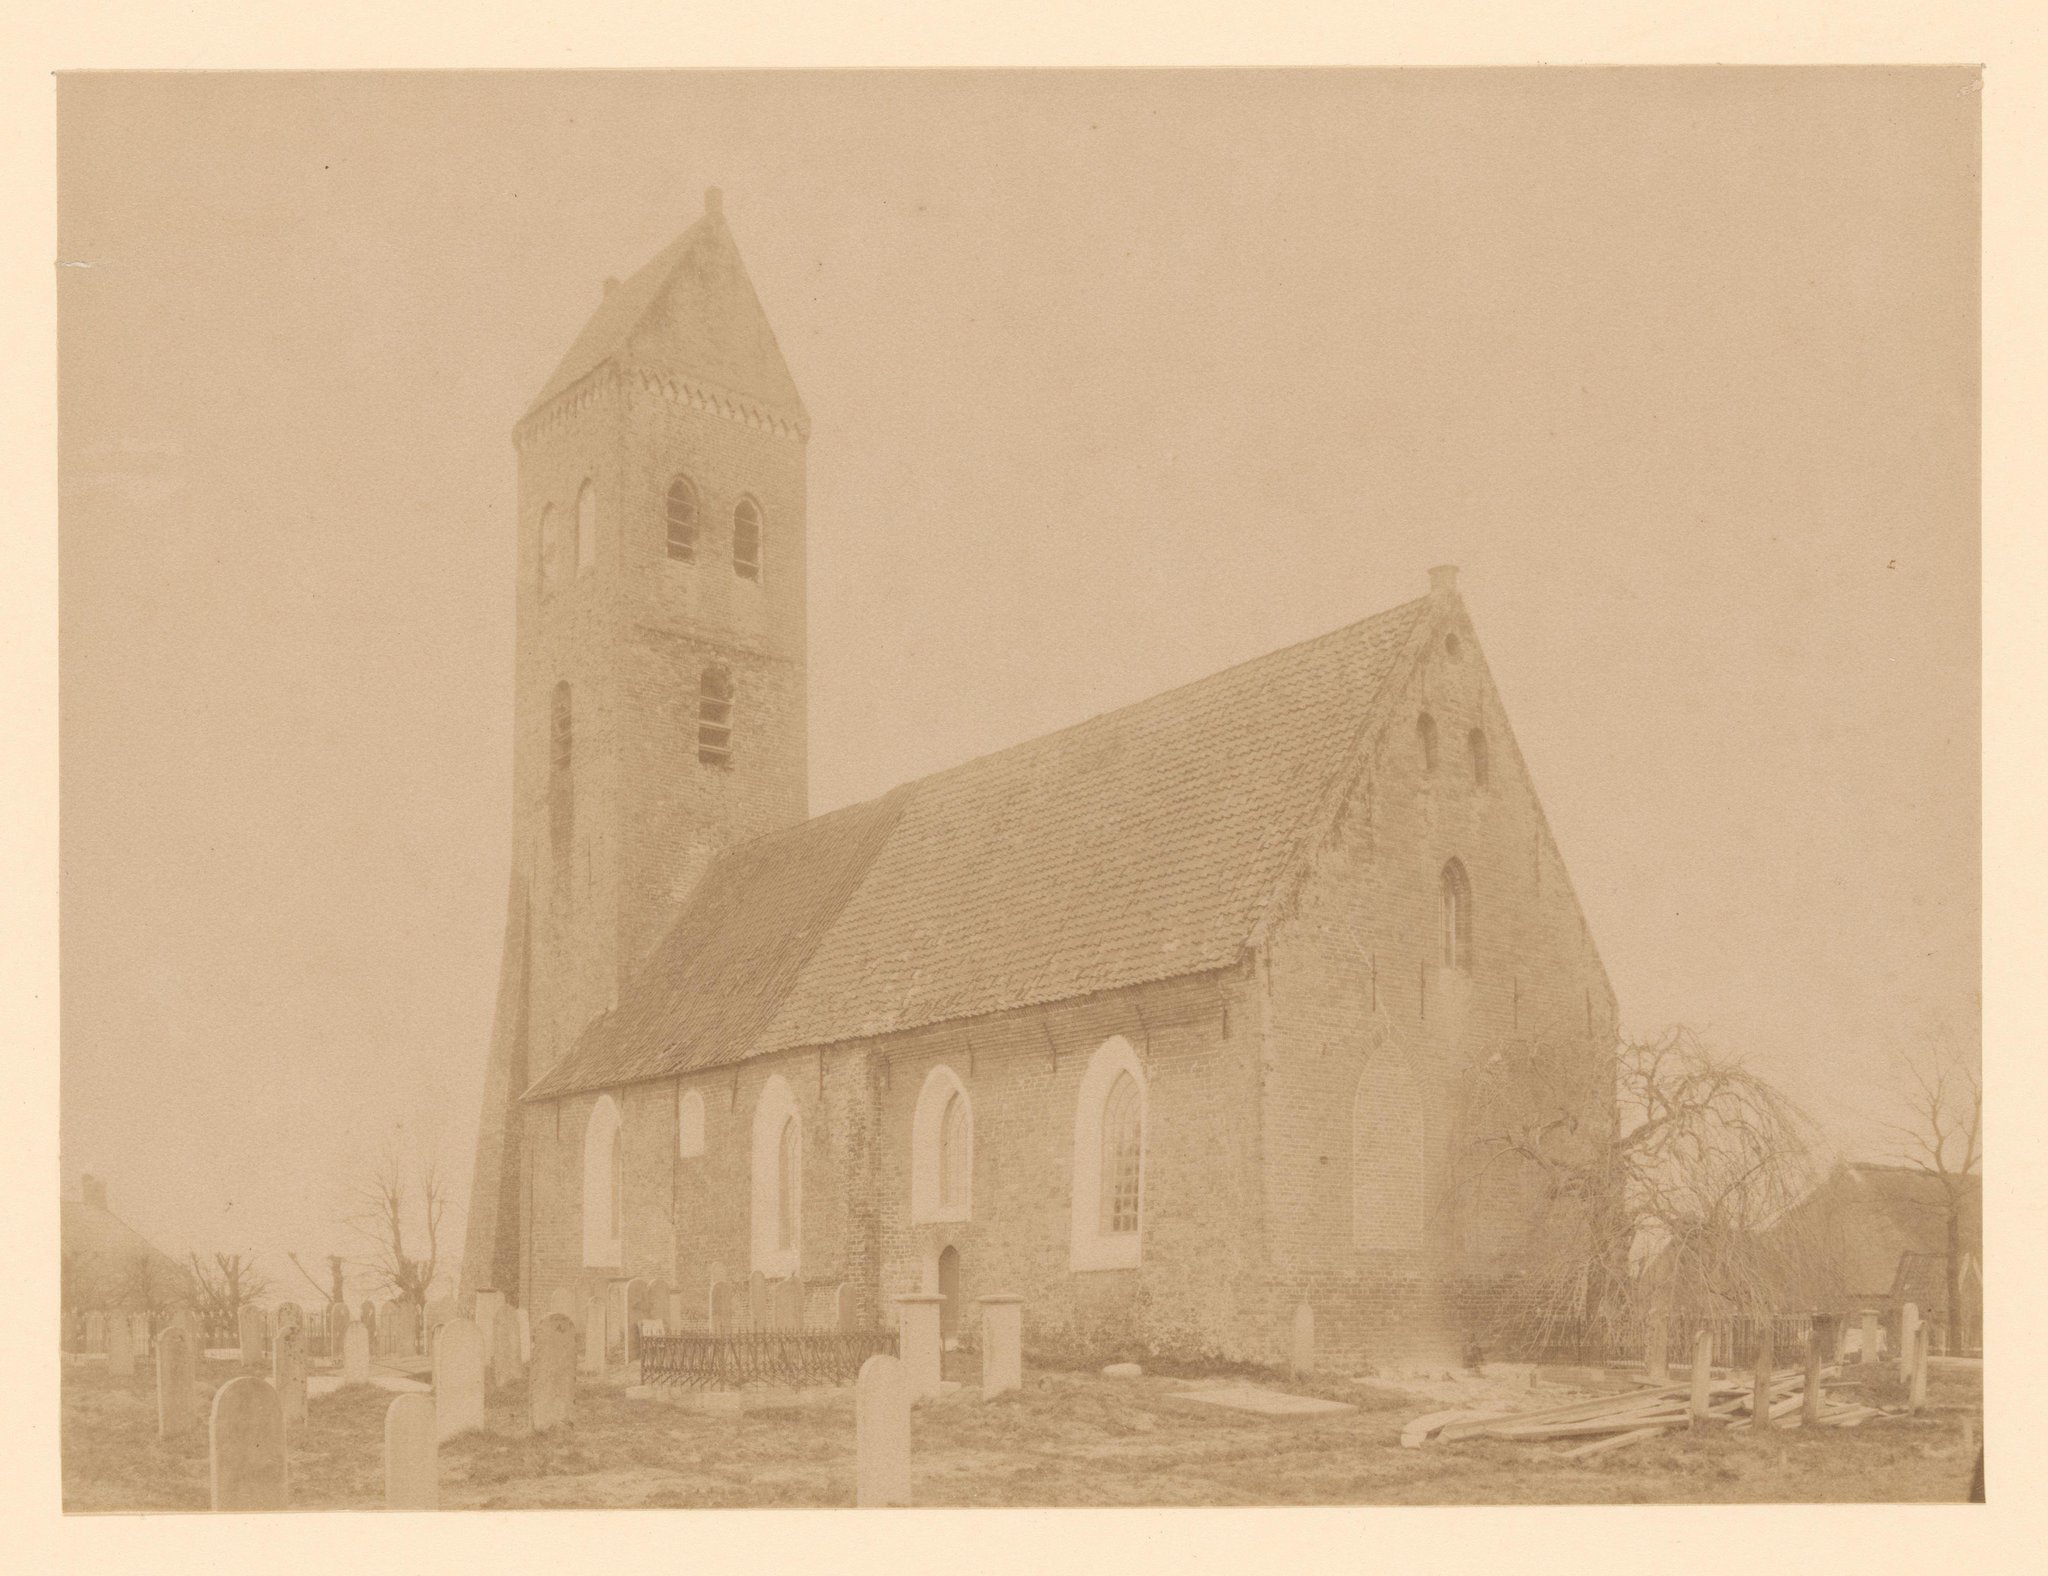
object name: photograph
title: Gezicht op de Hervormde Kerk te Midwolde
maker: anoniem (monumentenzorg)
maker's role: fotograaf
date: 1897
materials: cardboard, photographic support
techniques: albumen print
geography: midwolde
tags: church (exterior), churchyard, cemetery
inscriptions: annotation: ‘Kerk v/d Ned. Herv. gem. te Midwolde/ april 1897’, annotation: ‘Midwolde’